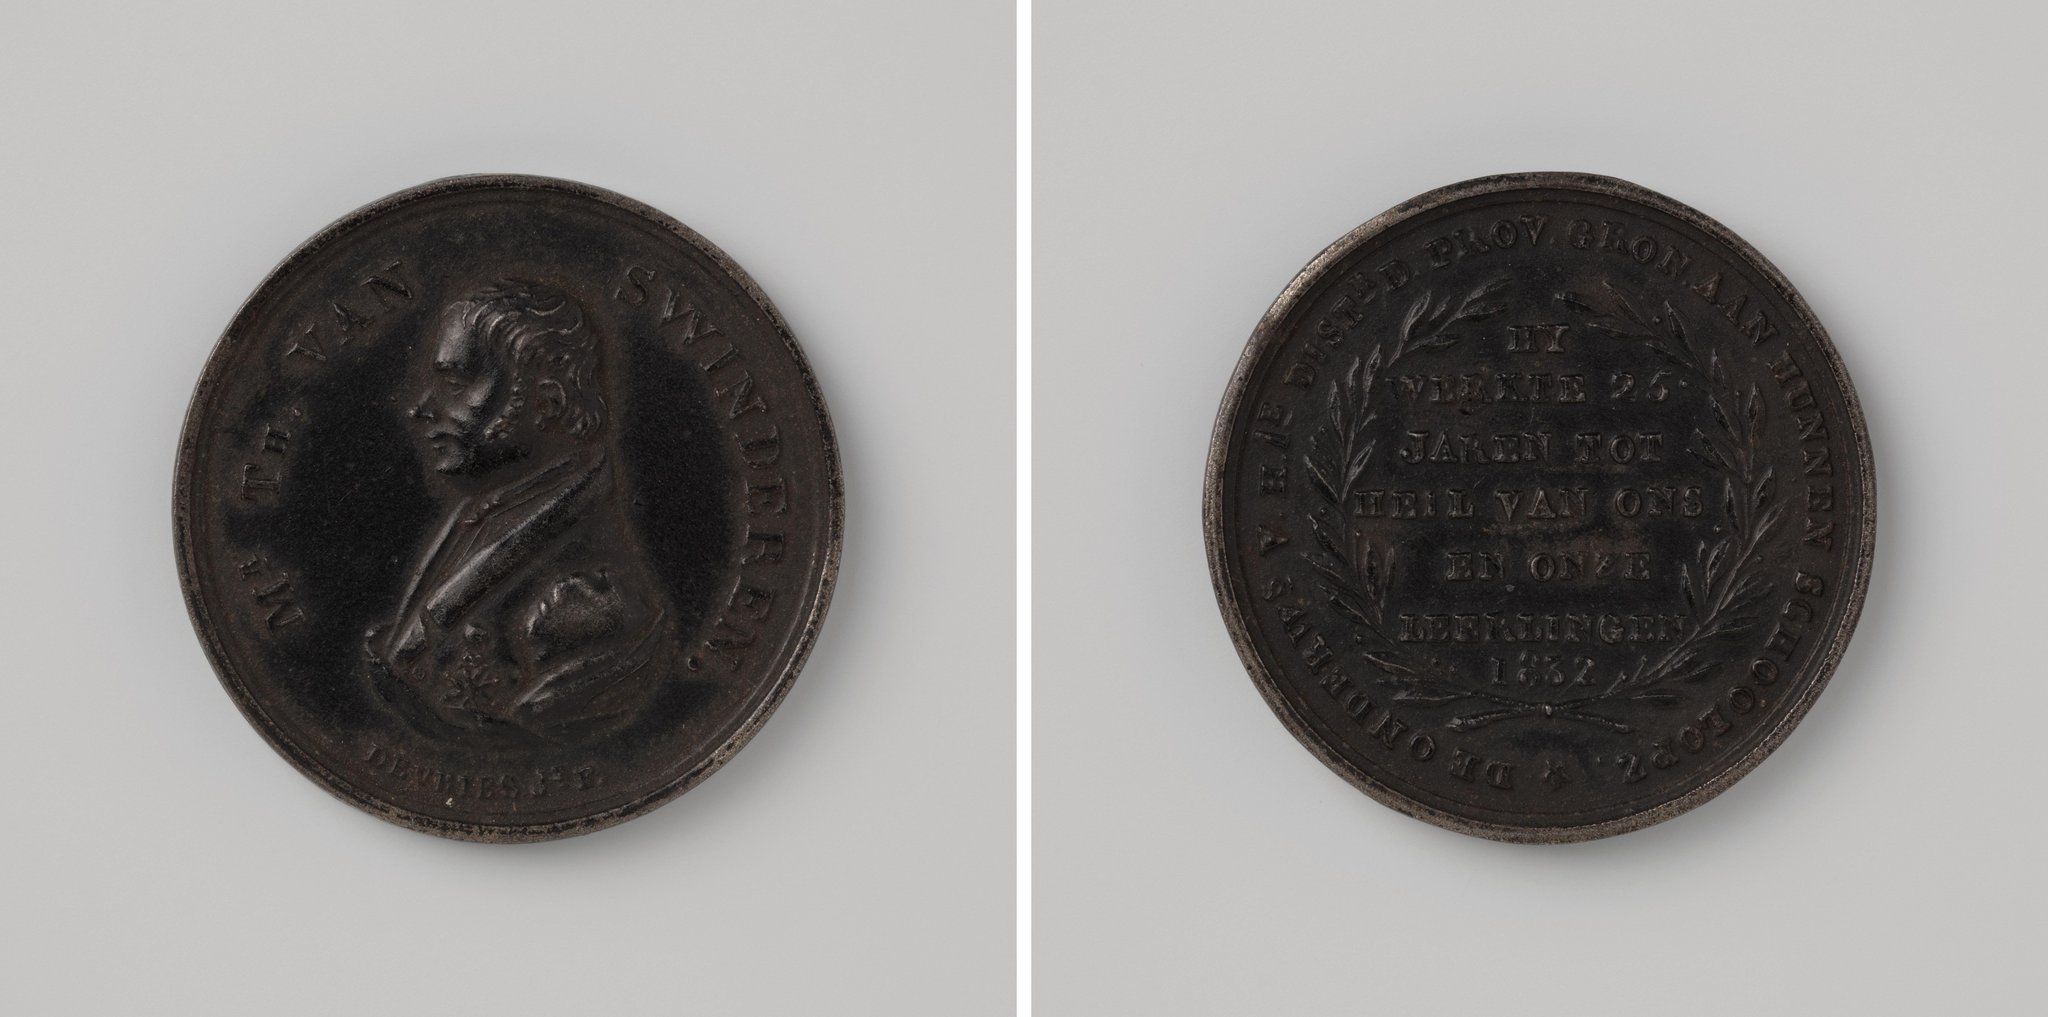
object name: history medal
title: Ter ere van Mr. Th. van Swinderen 1832, ijzeren afgietsel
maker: moses cohen de vries junior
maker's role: diamantslijper, graveur, medailleur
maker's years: 1807-1883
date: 1832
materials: iron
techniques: casting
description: Gegoten ijzeren penning, op de voorzijde het borstbeeld van Van Swinderen naar links met omschrift, op de keerzijde zeven regels tekst tussen lauwertakken, met omschrift.